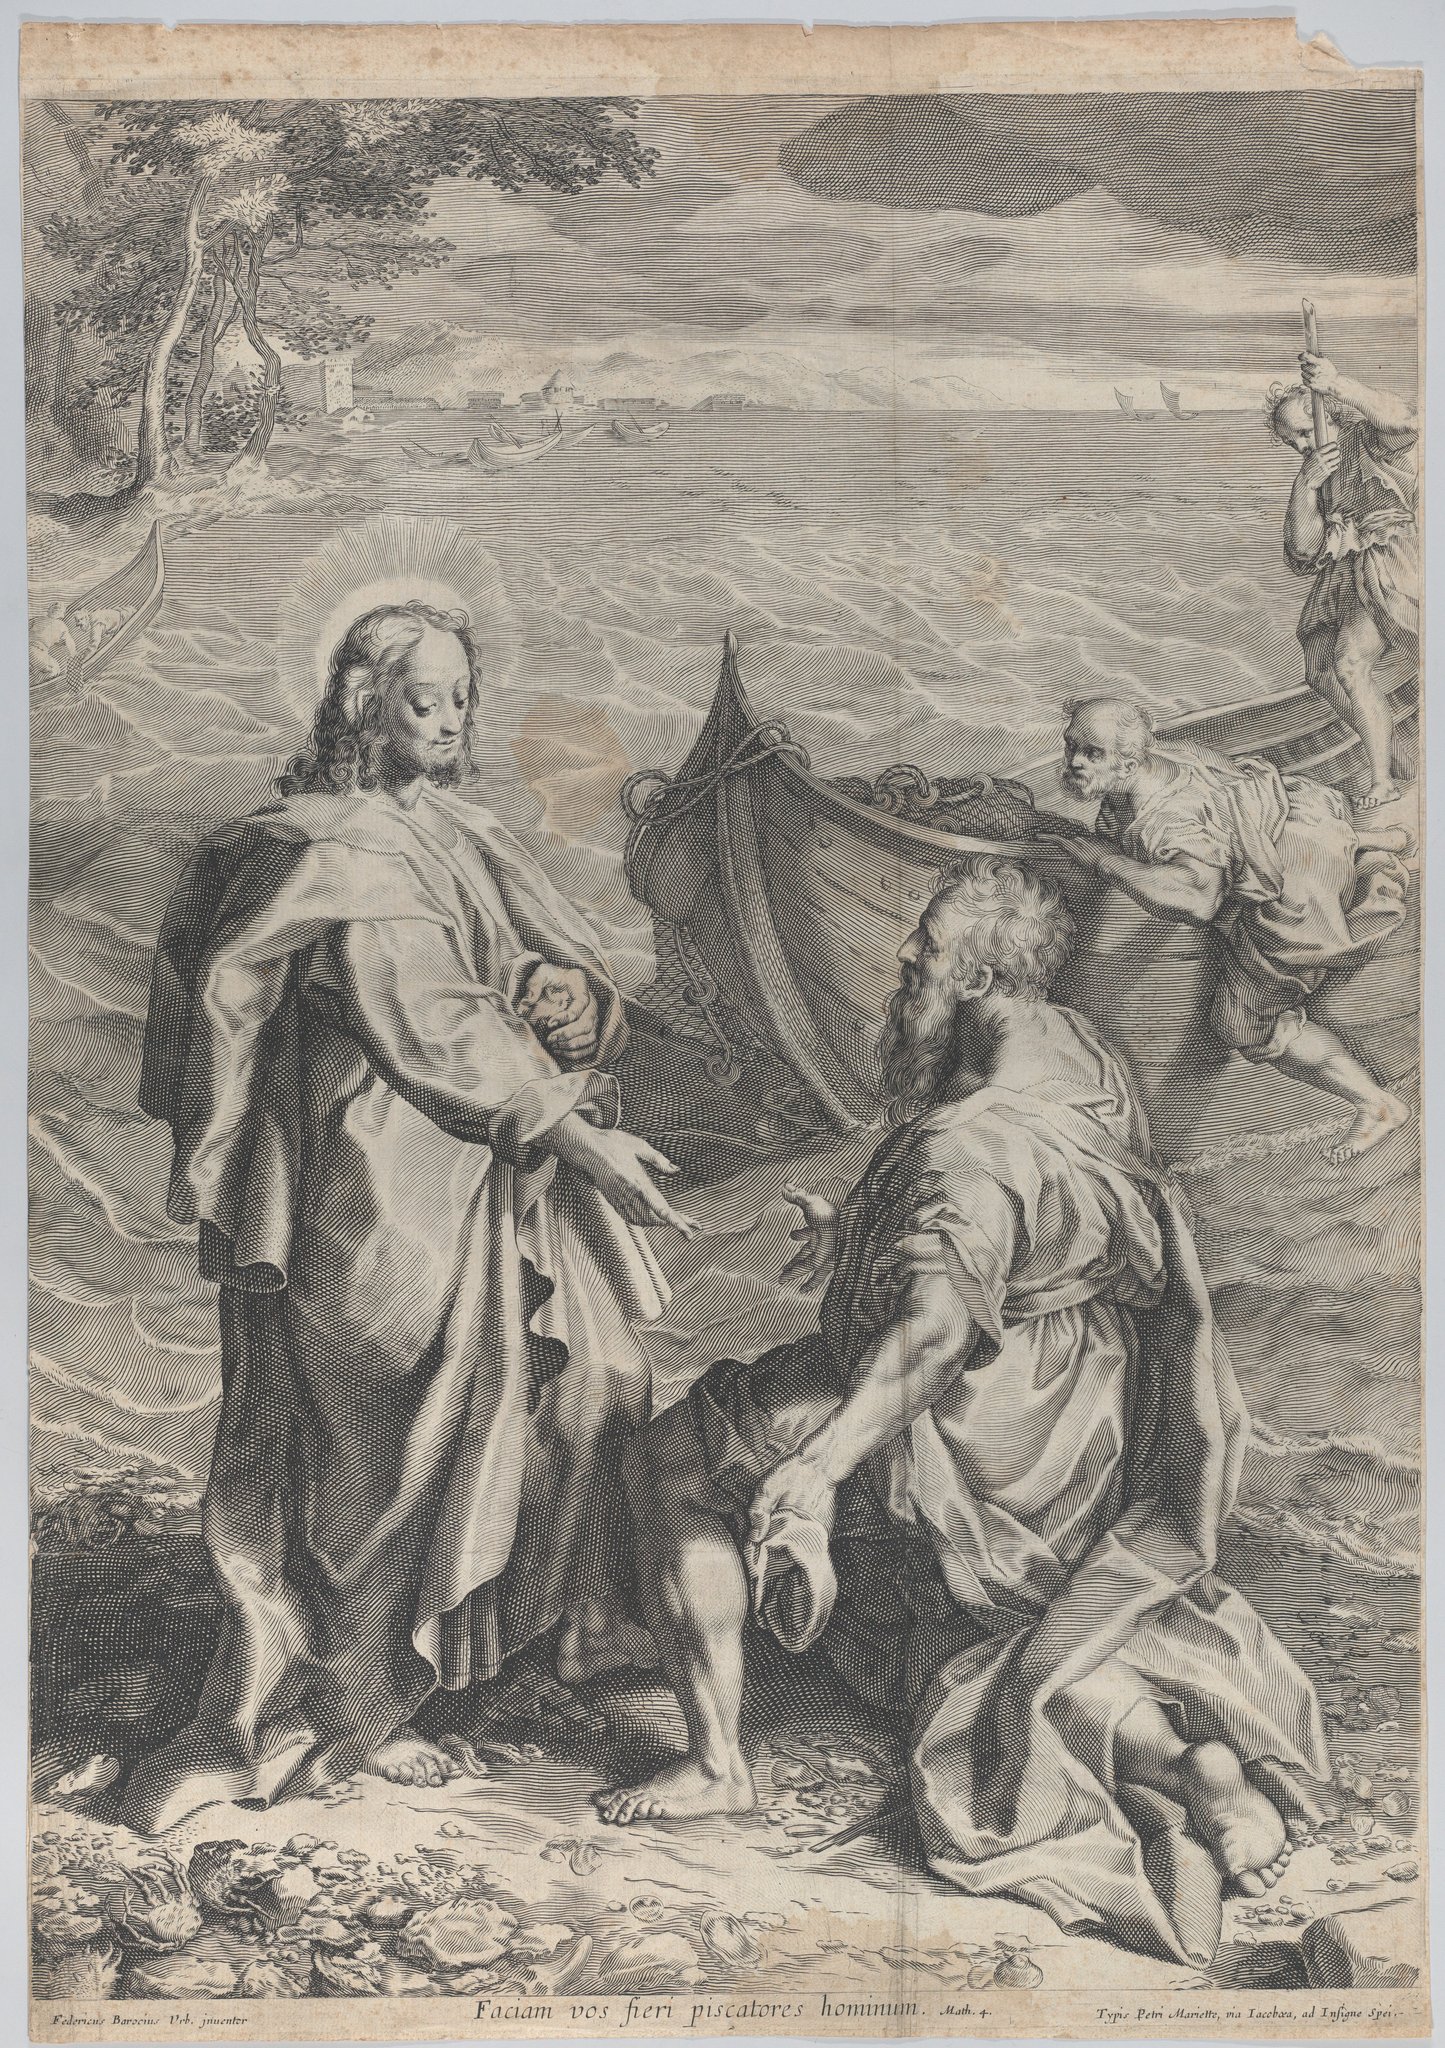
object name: print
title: Christ and Saint Peter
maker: Anonymous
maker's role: artist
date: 1743-1763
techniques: engraving